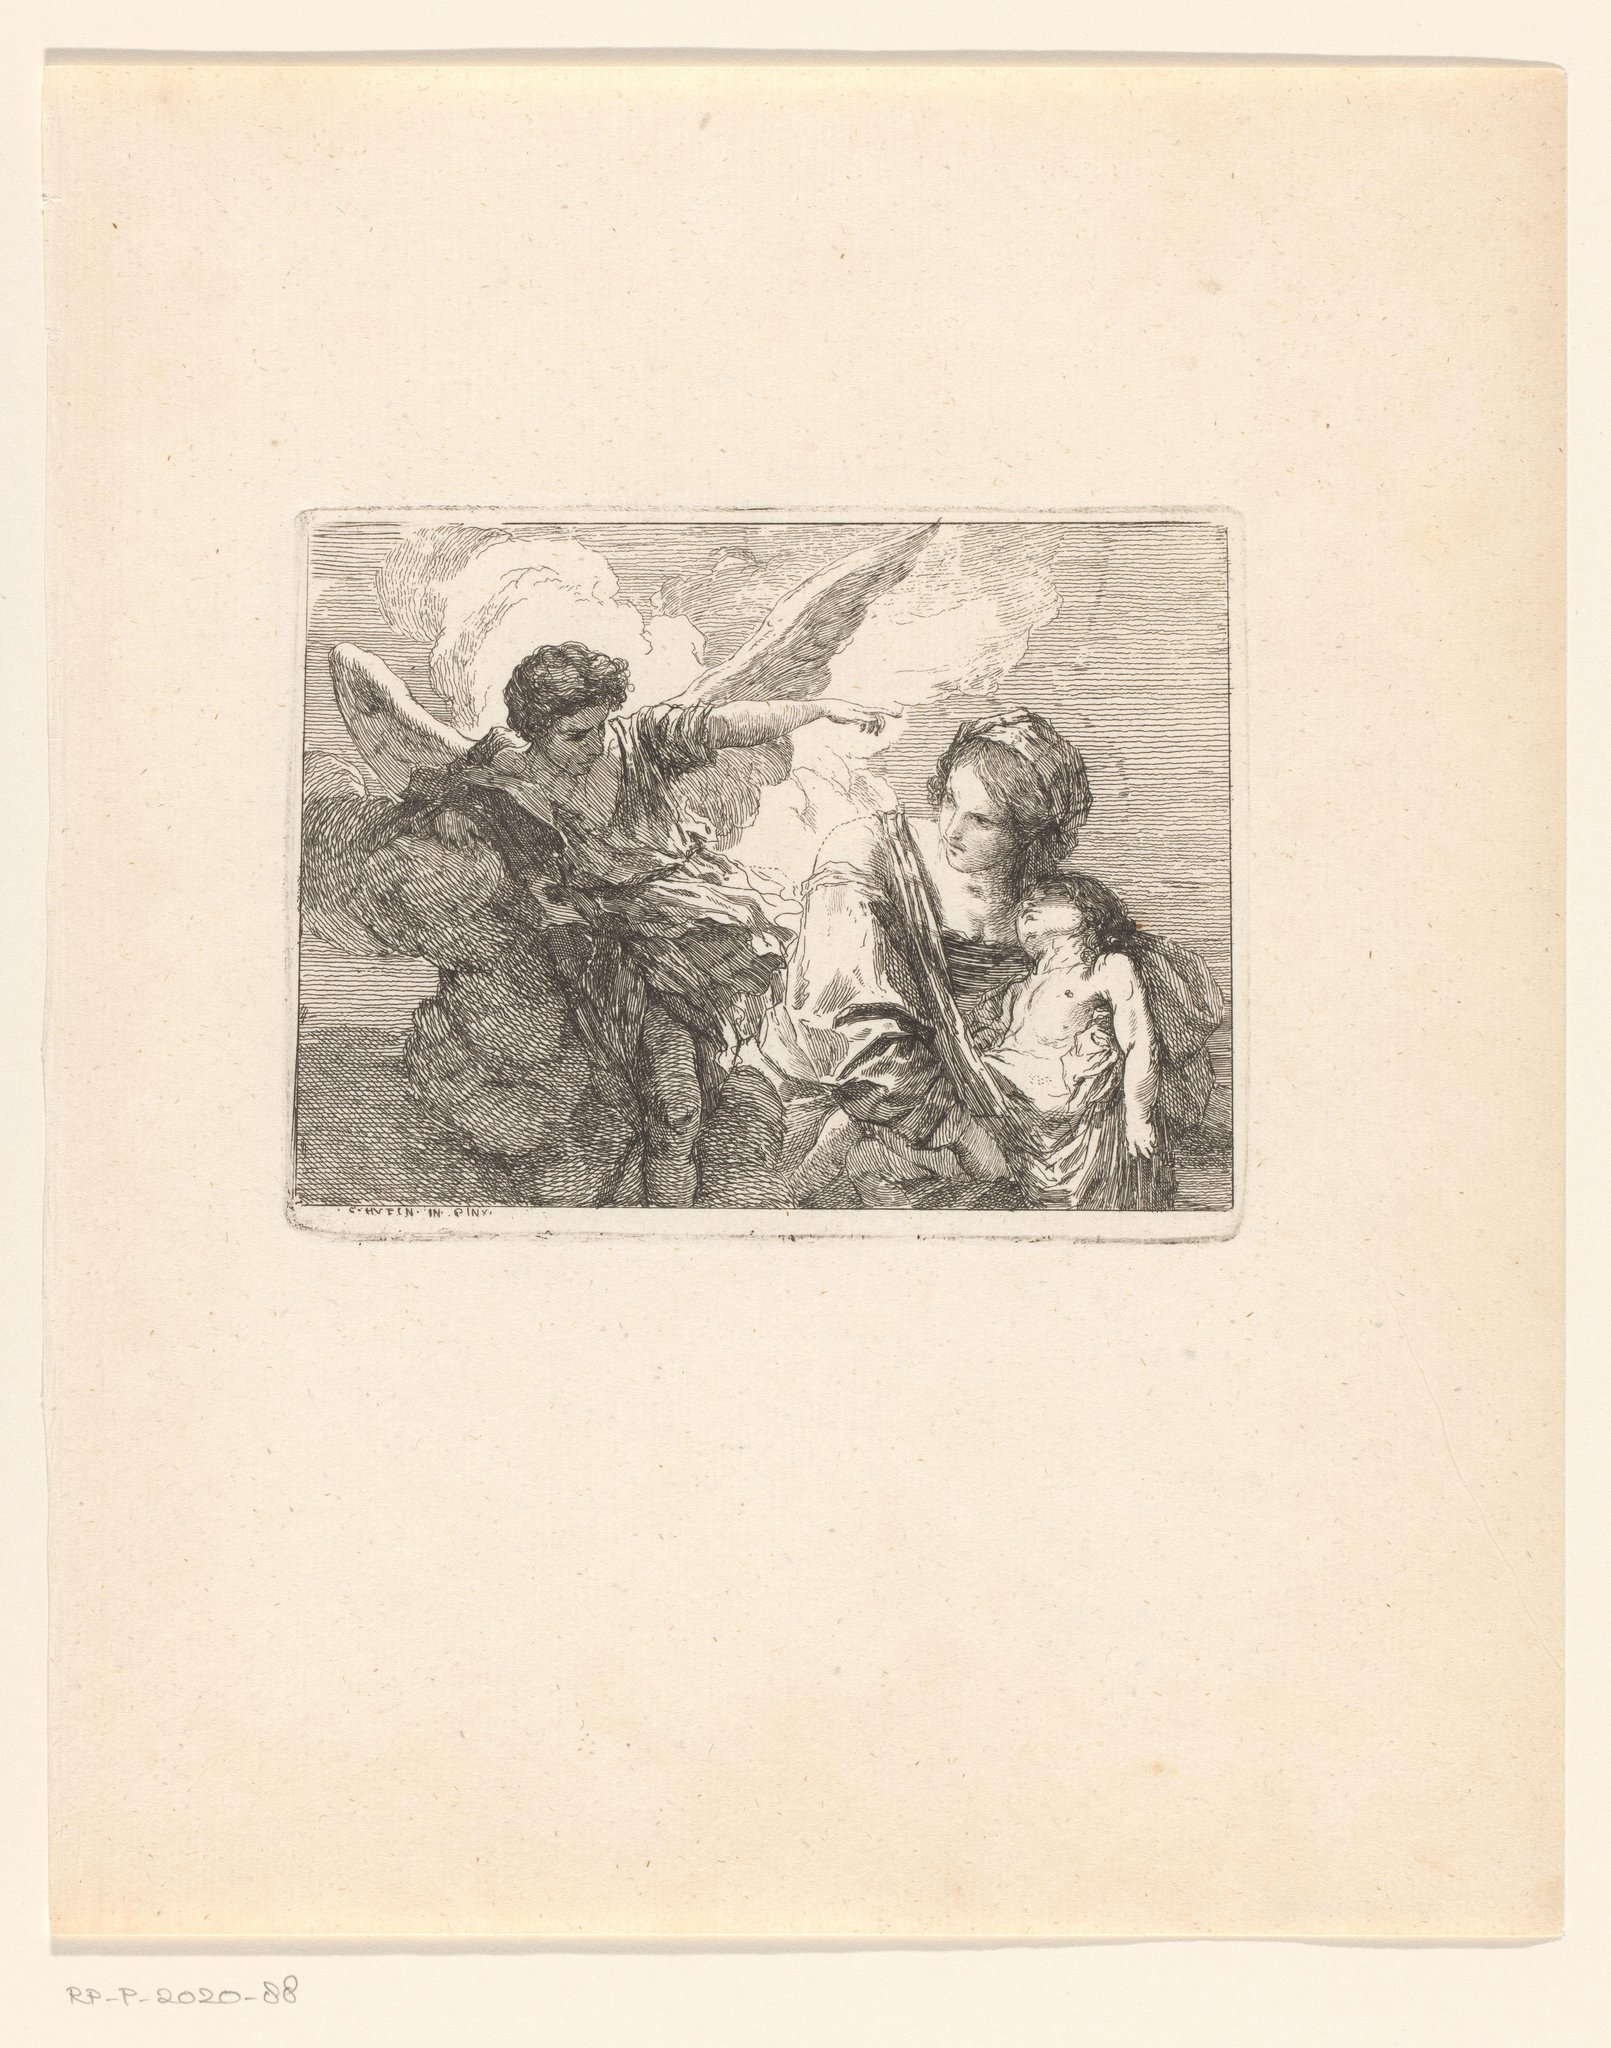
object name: print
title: De engel verschijnt aan Hagar en Ismael in de woestijn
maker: charles françois hutin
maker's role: draughtsman, print maker, sculptor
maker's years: 1715-1776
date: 1750-1775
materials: paper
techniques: etching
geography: paris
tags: an angel appears and reveals a well of water to hagar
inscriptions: collector's mark: Lugt 2228, collector's mark: Lugt 2760